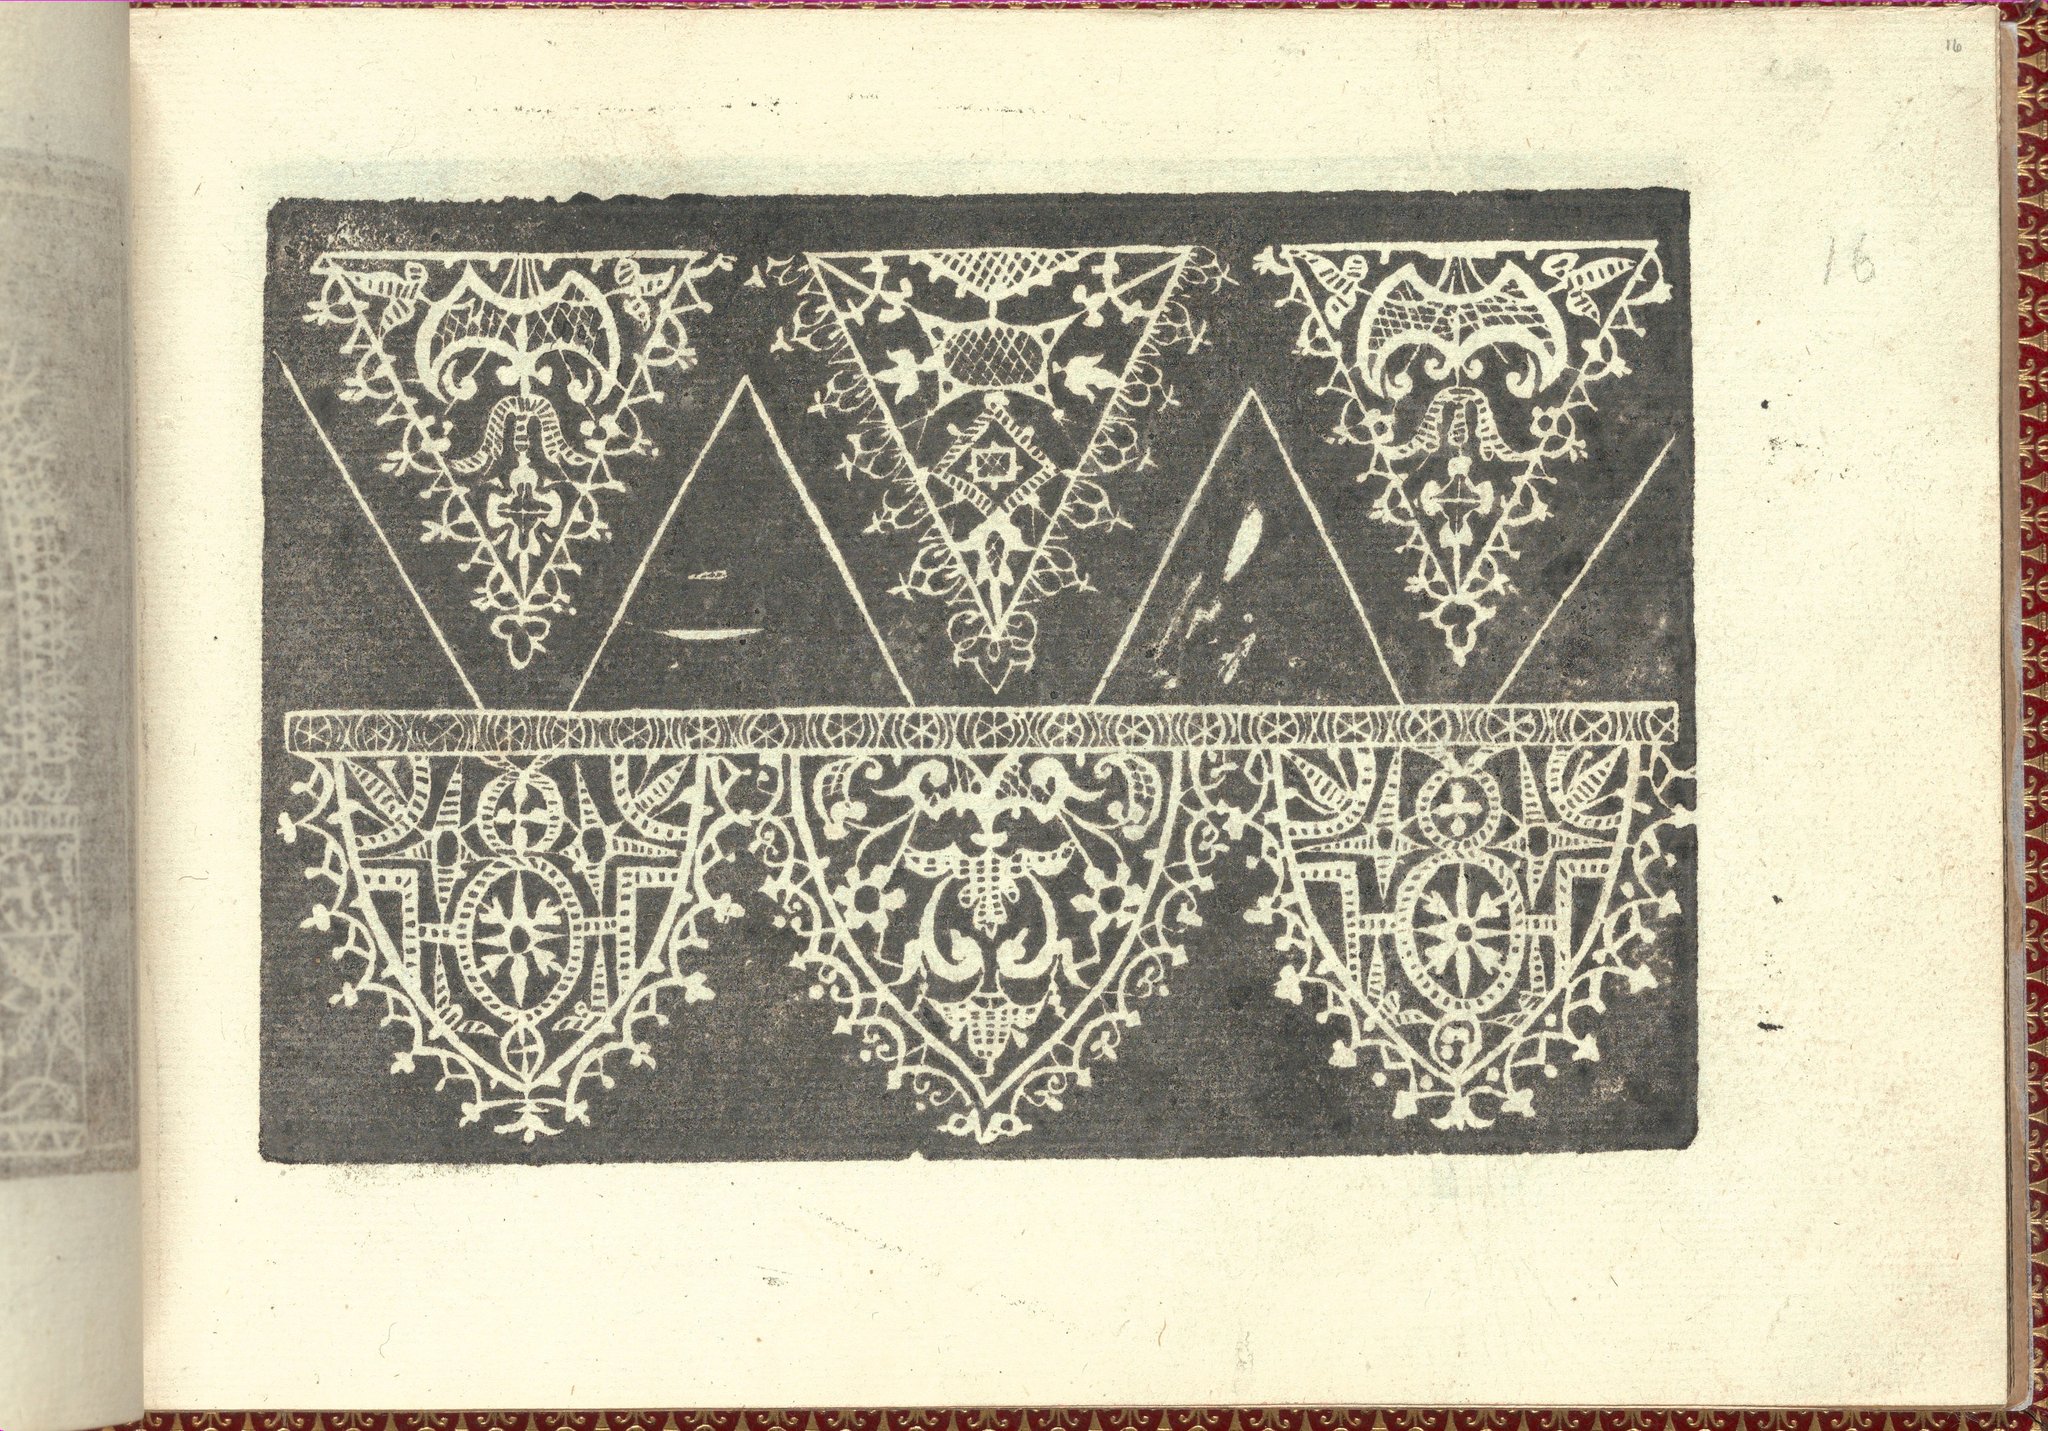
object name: book print ornament architecture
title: Corona delle Nobili et Virtuose Donne: Libro I-IV, page 16 (recto)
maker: cesare vecellio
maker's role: publisher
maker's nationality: italian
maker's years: 1521-1601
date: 1601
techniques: woodcut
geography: italy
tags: ornament